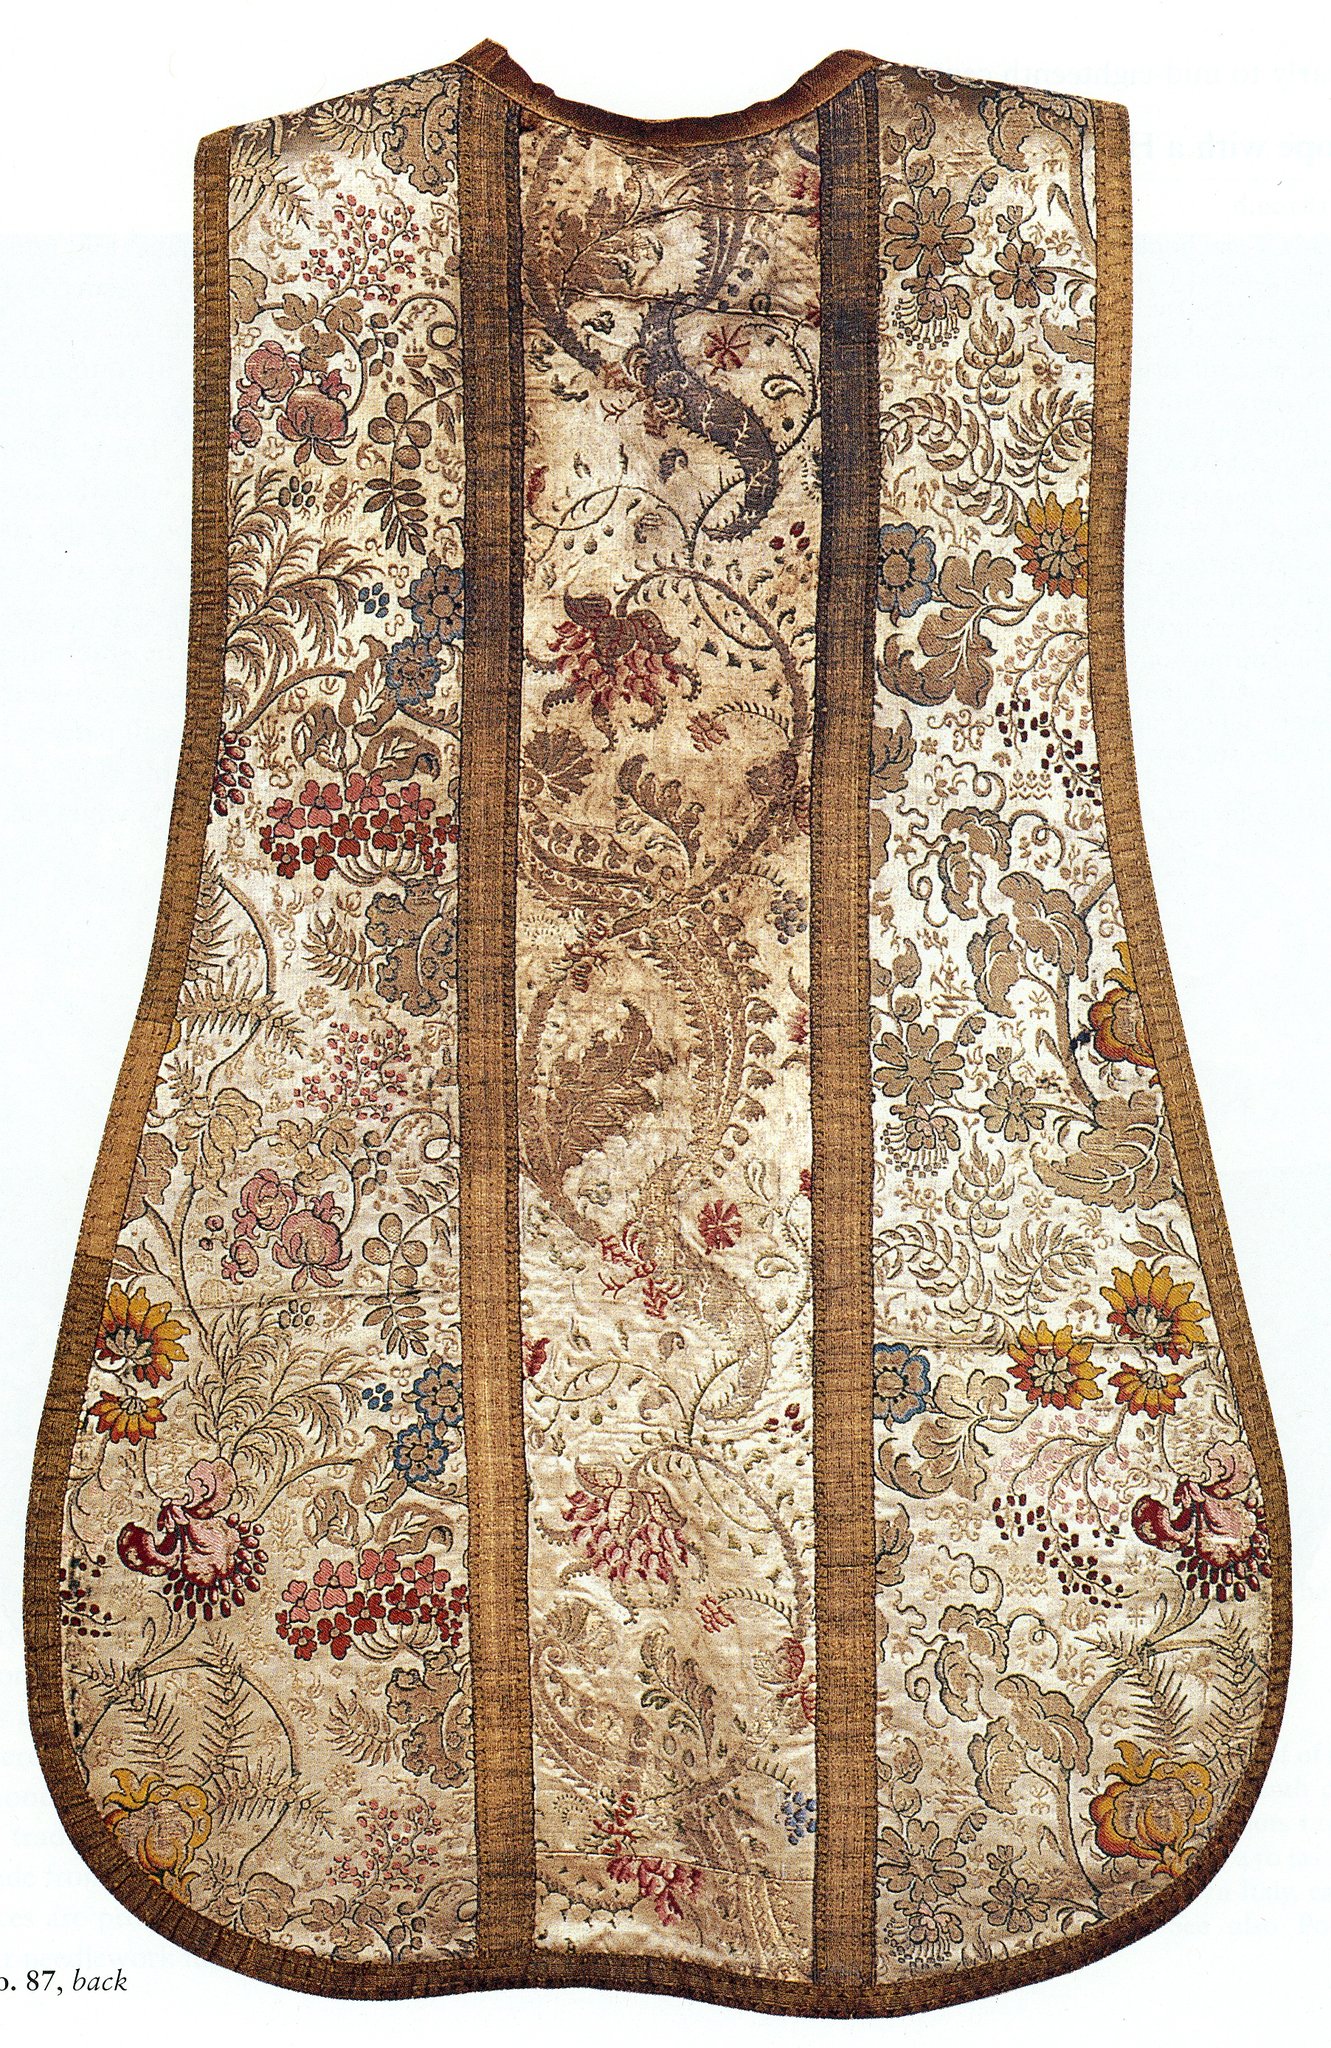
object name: chasuble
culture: italian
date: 1701-1733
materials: cotton, hemp, metal, silk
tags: flowers